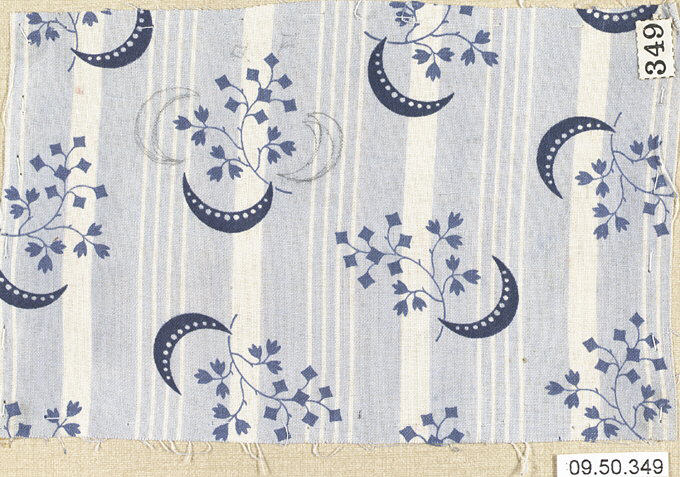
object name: piece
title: Piece (one of 116)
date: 1801-1900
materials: cotton